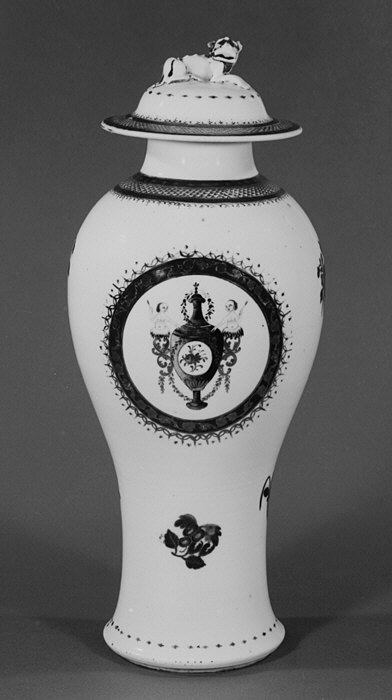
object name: vase with cover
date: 1790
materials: hard paste porcelain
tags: animals,insignia